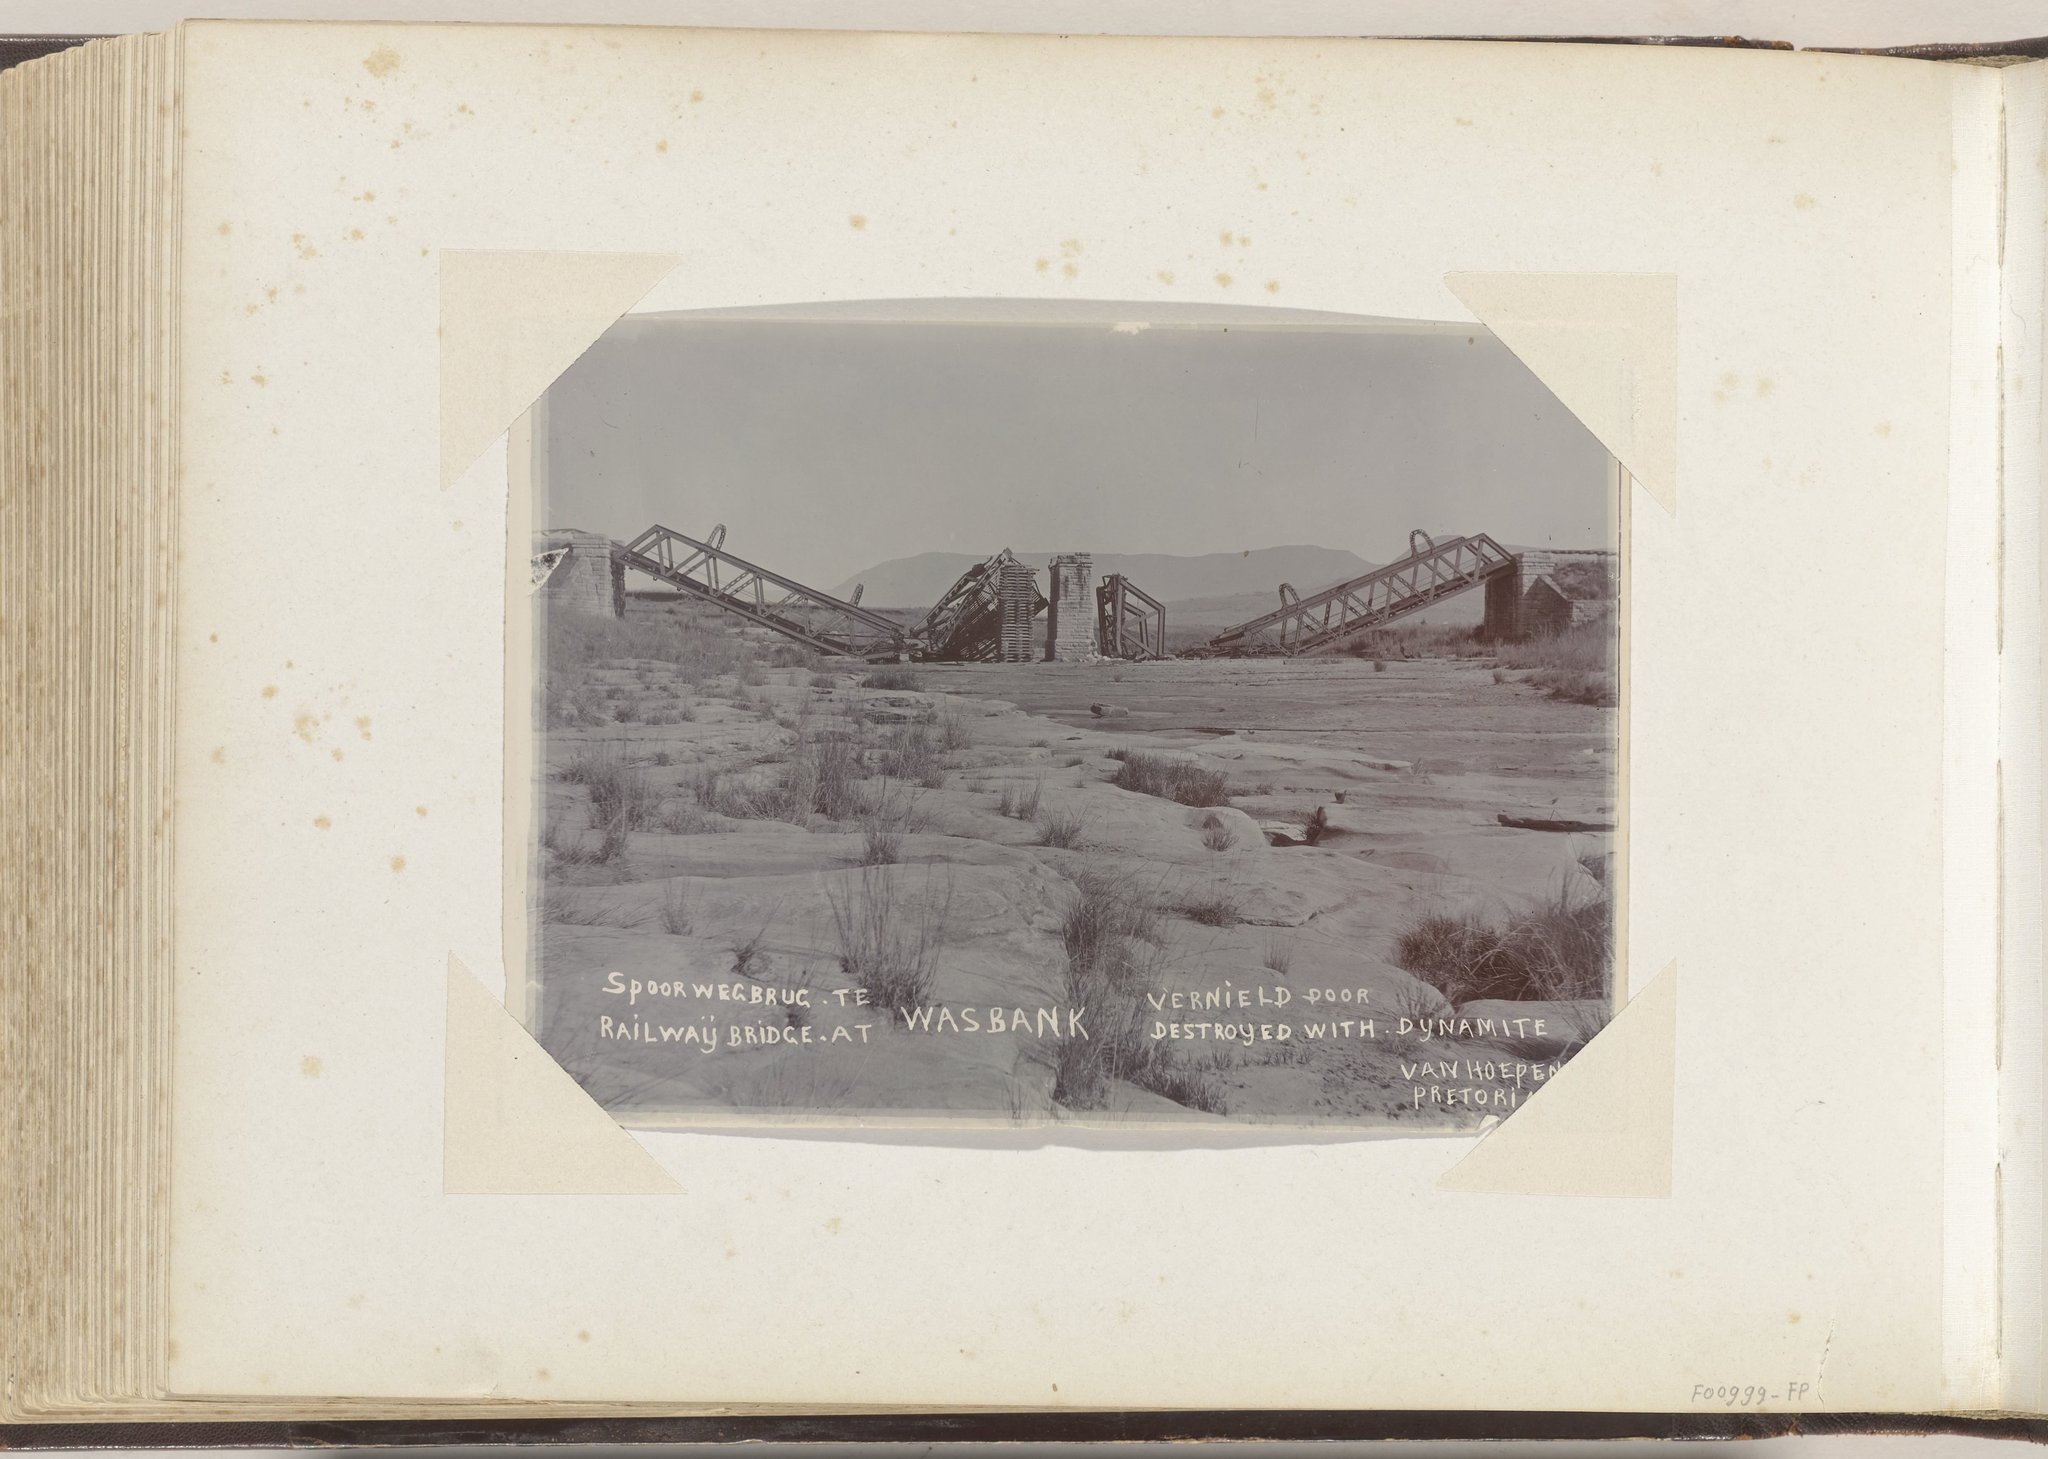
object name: photograph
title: Spoorwegbrug te Wasbank vernield door dynamite / Railwaij- bridge at Wasbank destroyed by dynamite.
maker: jan van hoepen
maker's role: fotograaf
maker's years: 1856-1922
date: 1899-1900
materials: paper, photographic support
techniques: gelatin silver print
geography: wasbank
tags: landscape with bridge, viaduct or aqueduct, bridge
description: Onderdeel van Album met 191 foto's van een reis naar en door Zuid-Afrika.